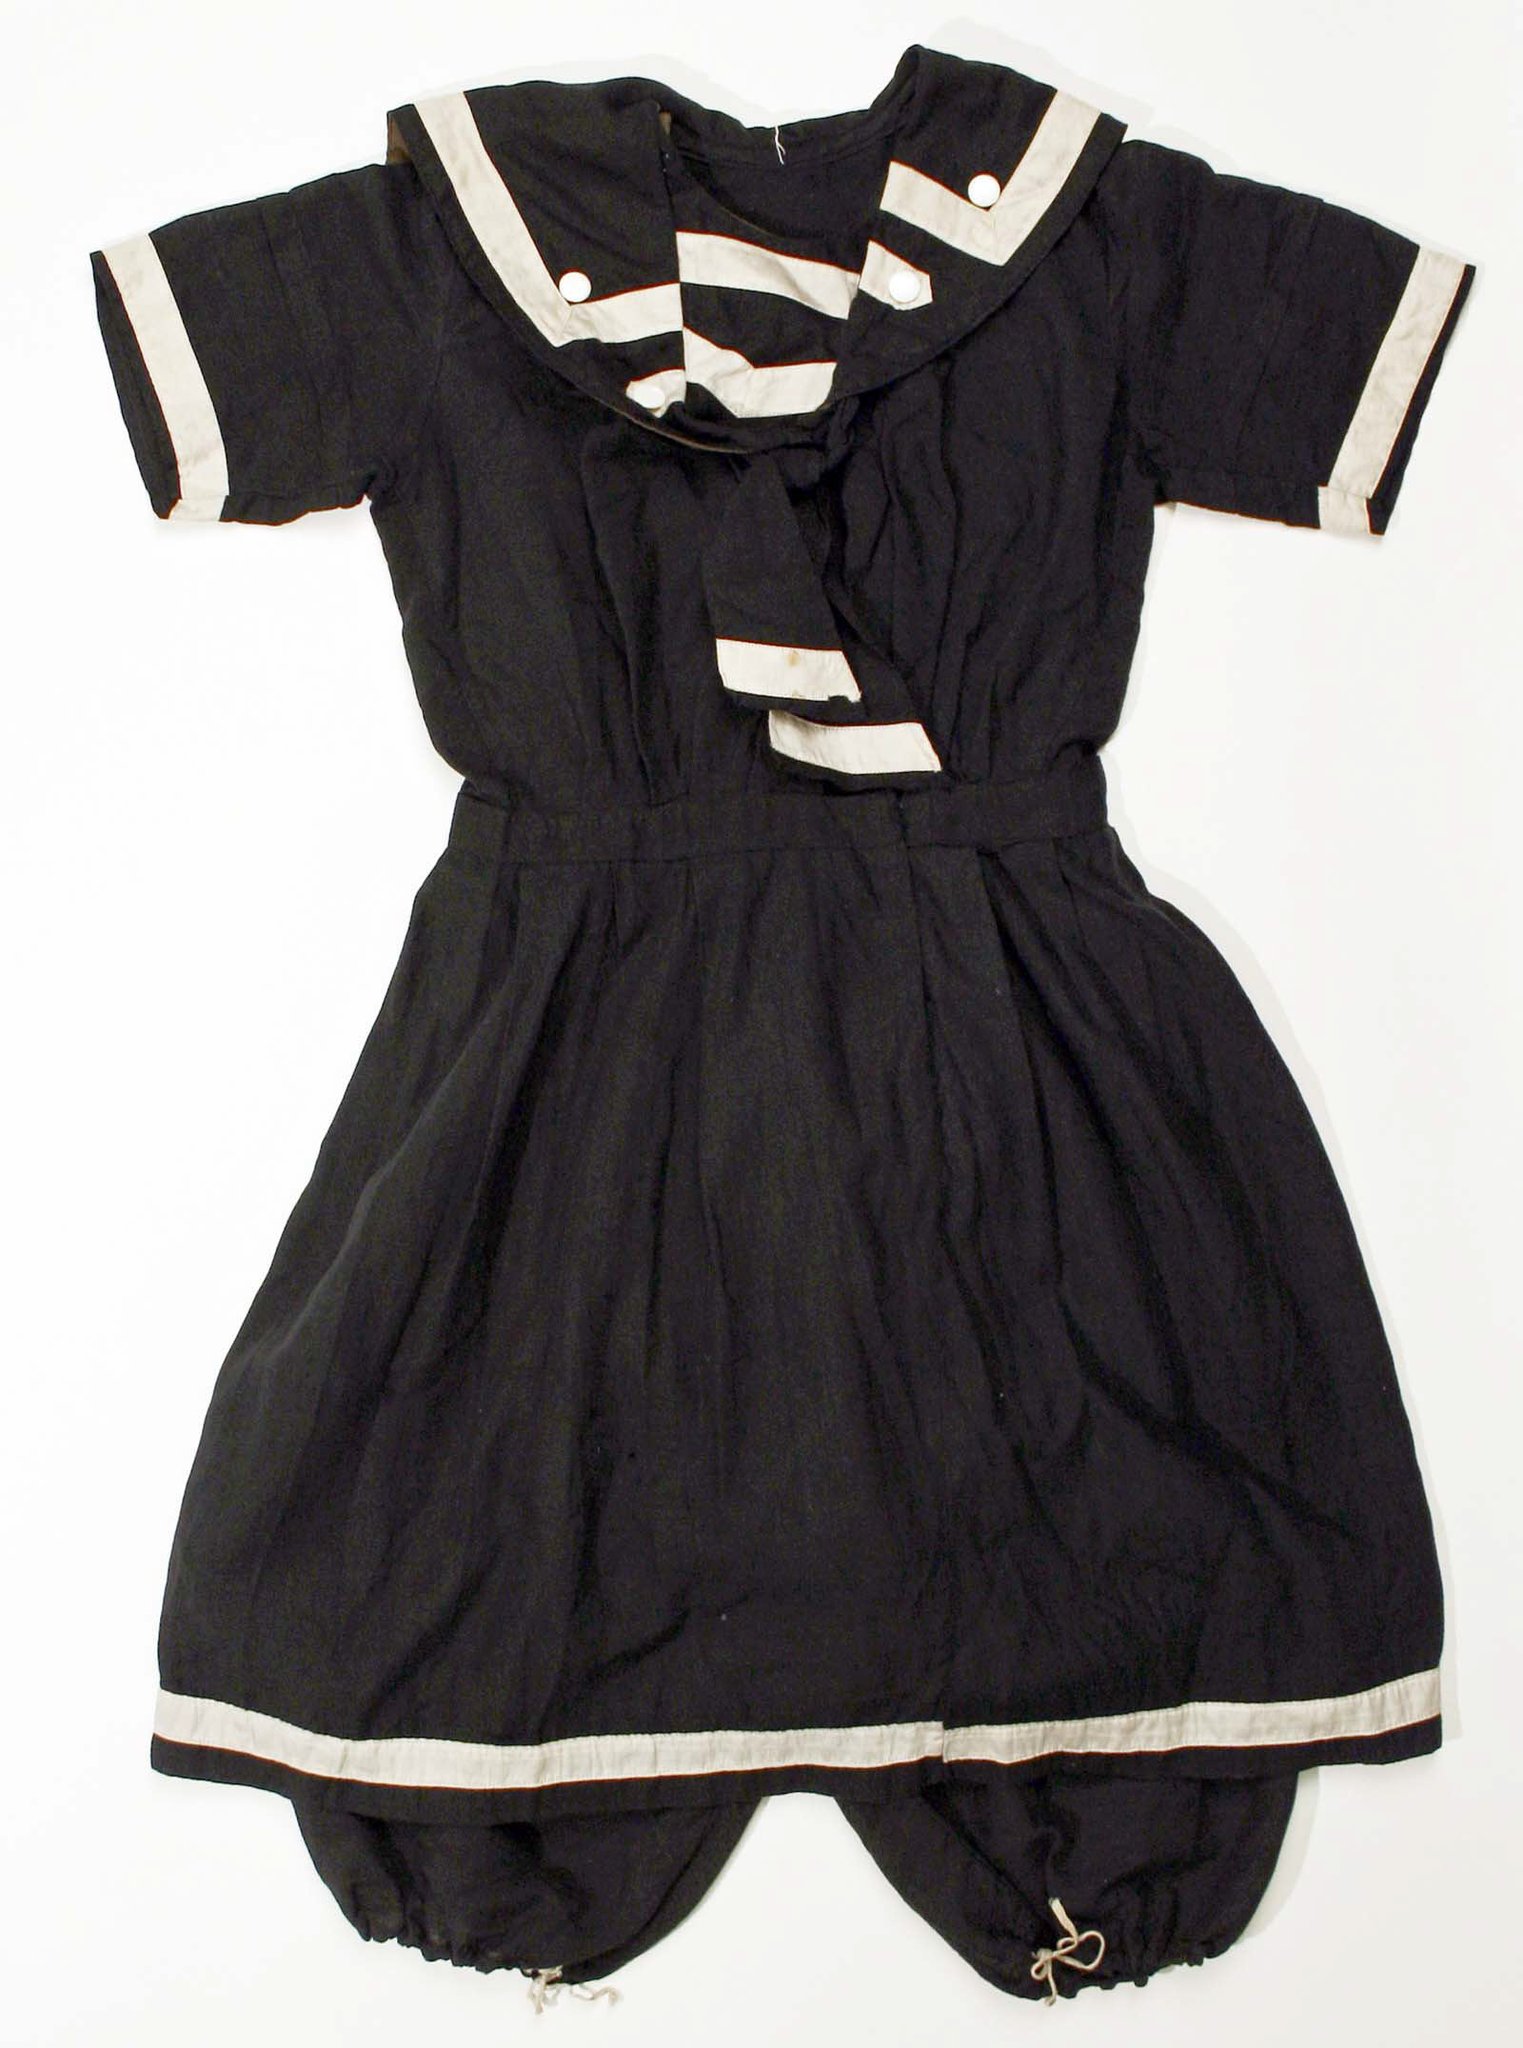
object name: beachwear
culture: american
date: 1895-1899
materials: cotton